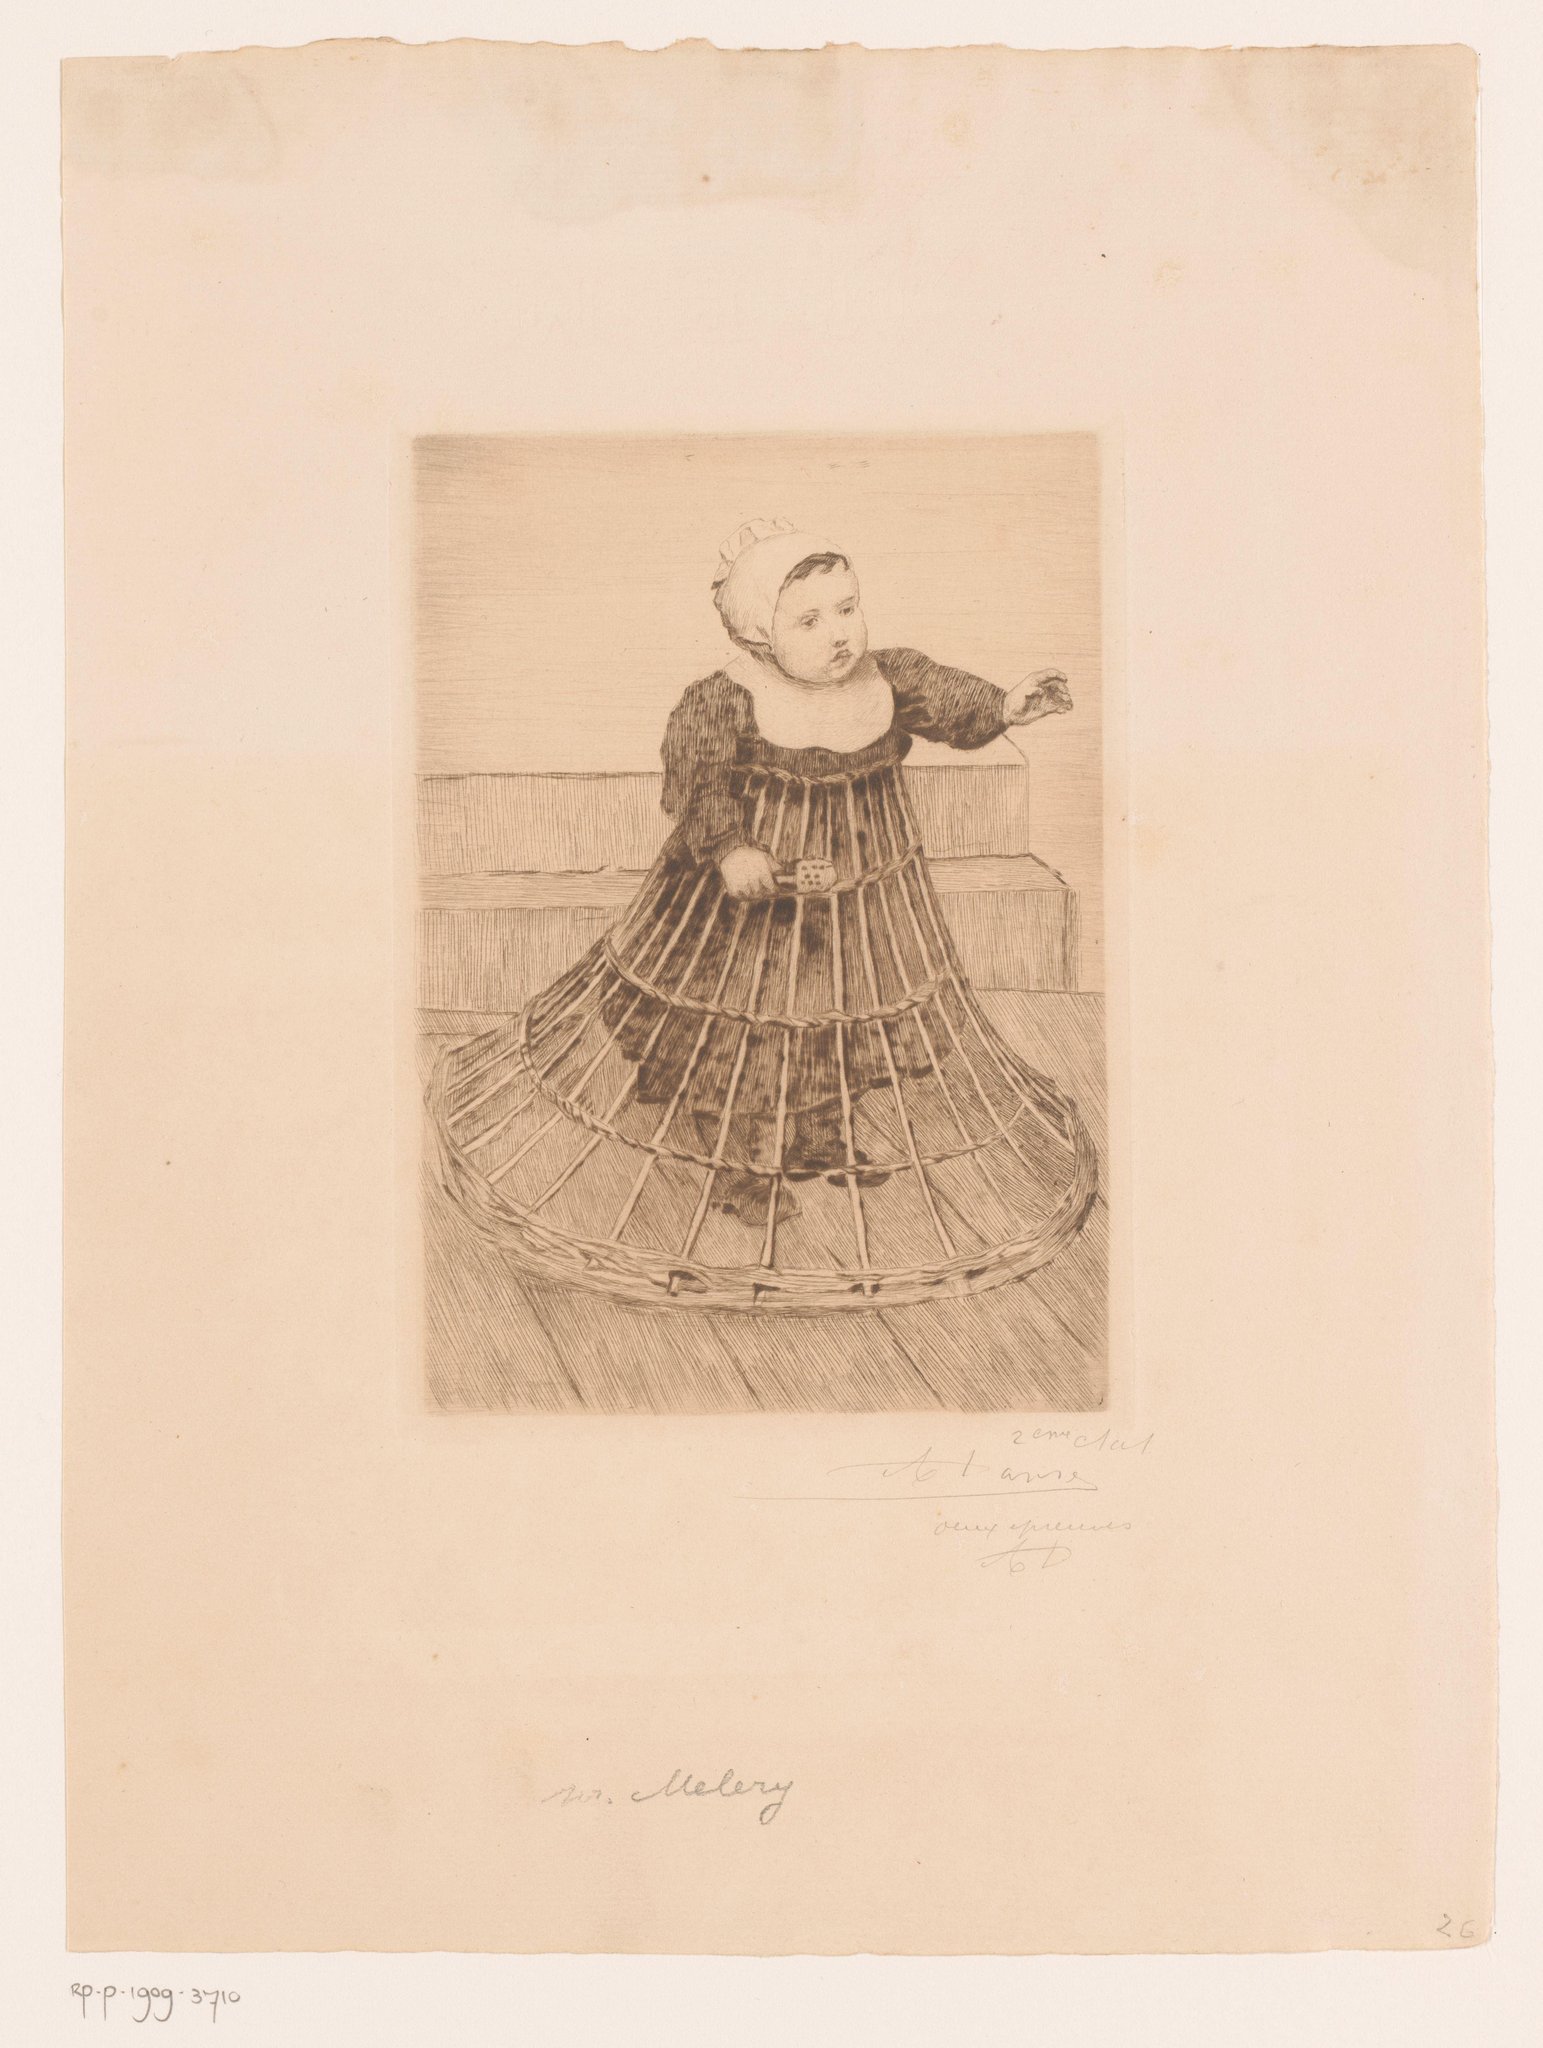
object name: print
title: Jong meisje, staand in een looprek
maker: auguste danse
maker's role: print maker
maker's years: 1829-1929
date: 1839-1909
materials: paper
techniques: drypoint, etching, intaglio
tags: implements for learning to walk, go-cart - aa - girl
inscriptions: collector's mark: Lugt 2228, annotation: ‘2eme etat; deux epreuves’